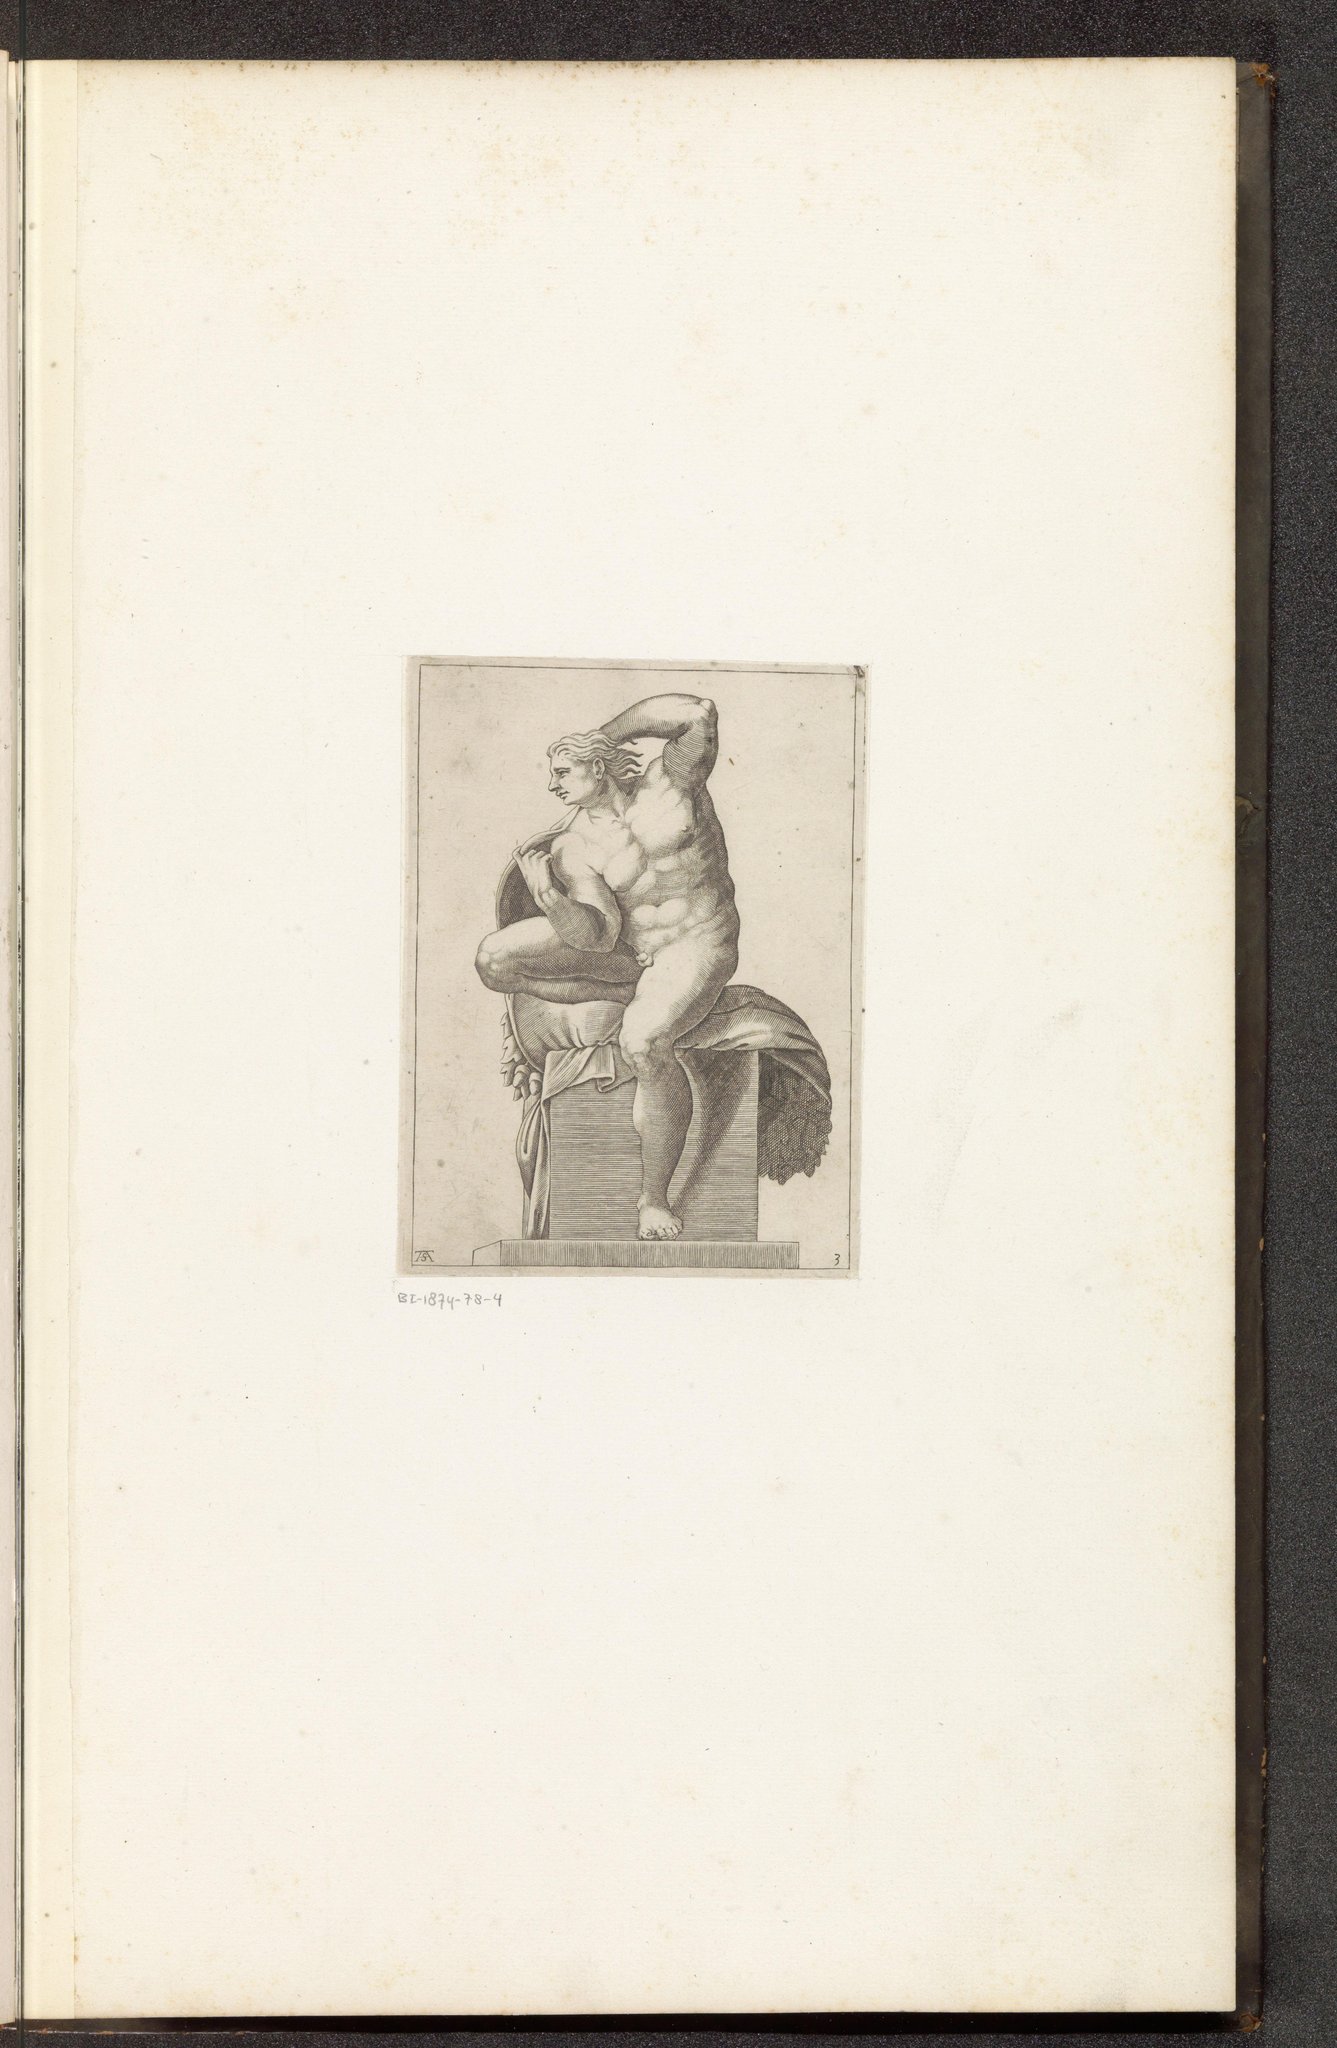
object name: print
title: Schilderingen in de Sixtijnse kapel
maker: adamo scultori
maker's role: painter, print maker, sculptor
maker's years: 1530-1585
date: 1585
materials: paper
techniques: engraving, intaglio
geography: italy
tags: the (nude) human figure; 'corpo humano' (ripa), fruits: acorn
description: Naakte man, staand op één been en naar links gedraaid, met een guirlande van eikels. Eén van de 'ignudi' (naakte mannen) van Michelangelo's plafondschildering. Genummerd rechtsonder: 3. De prent maakt deel uit van een album.